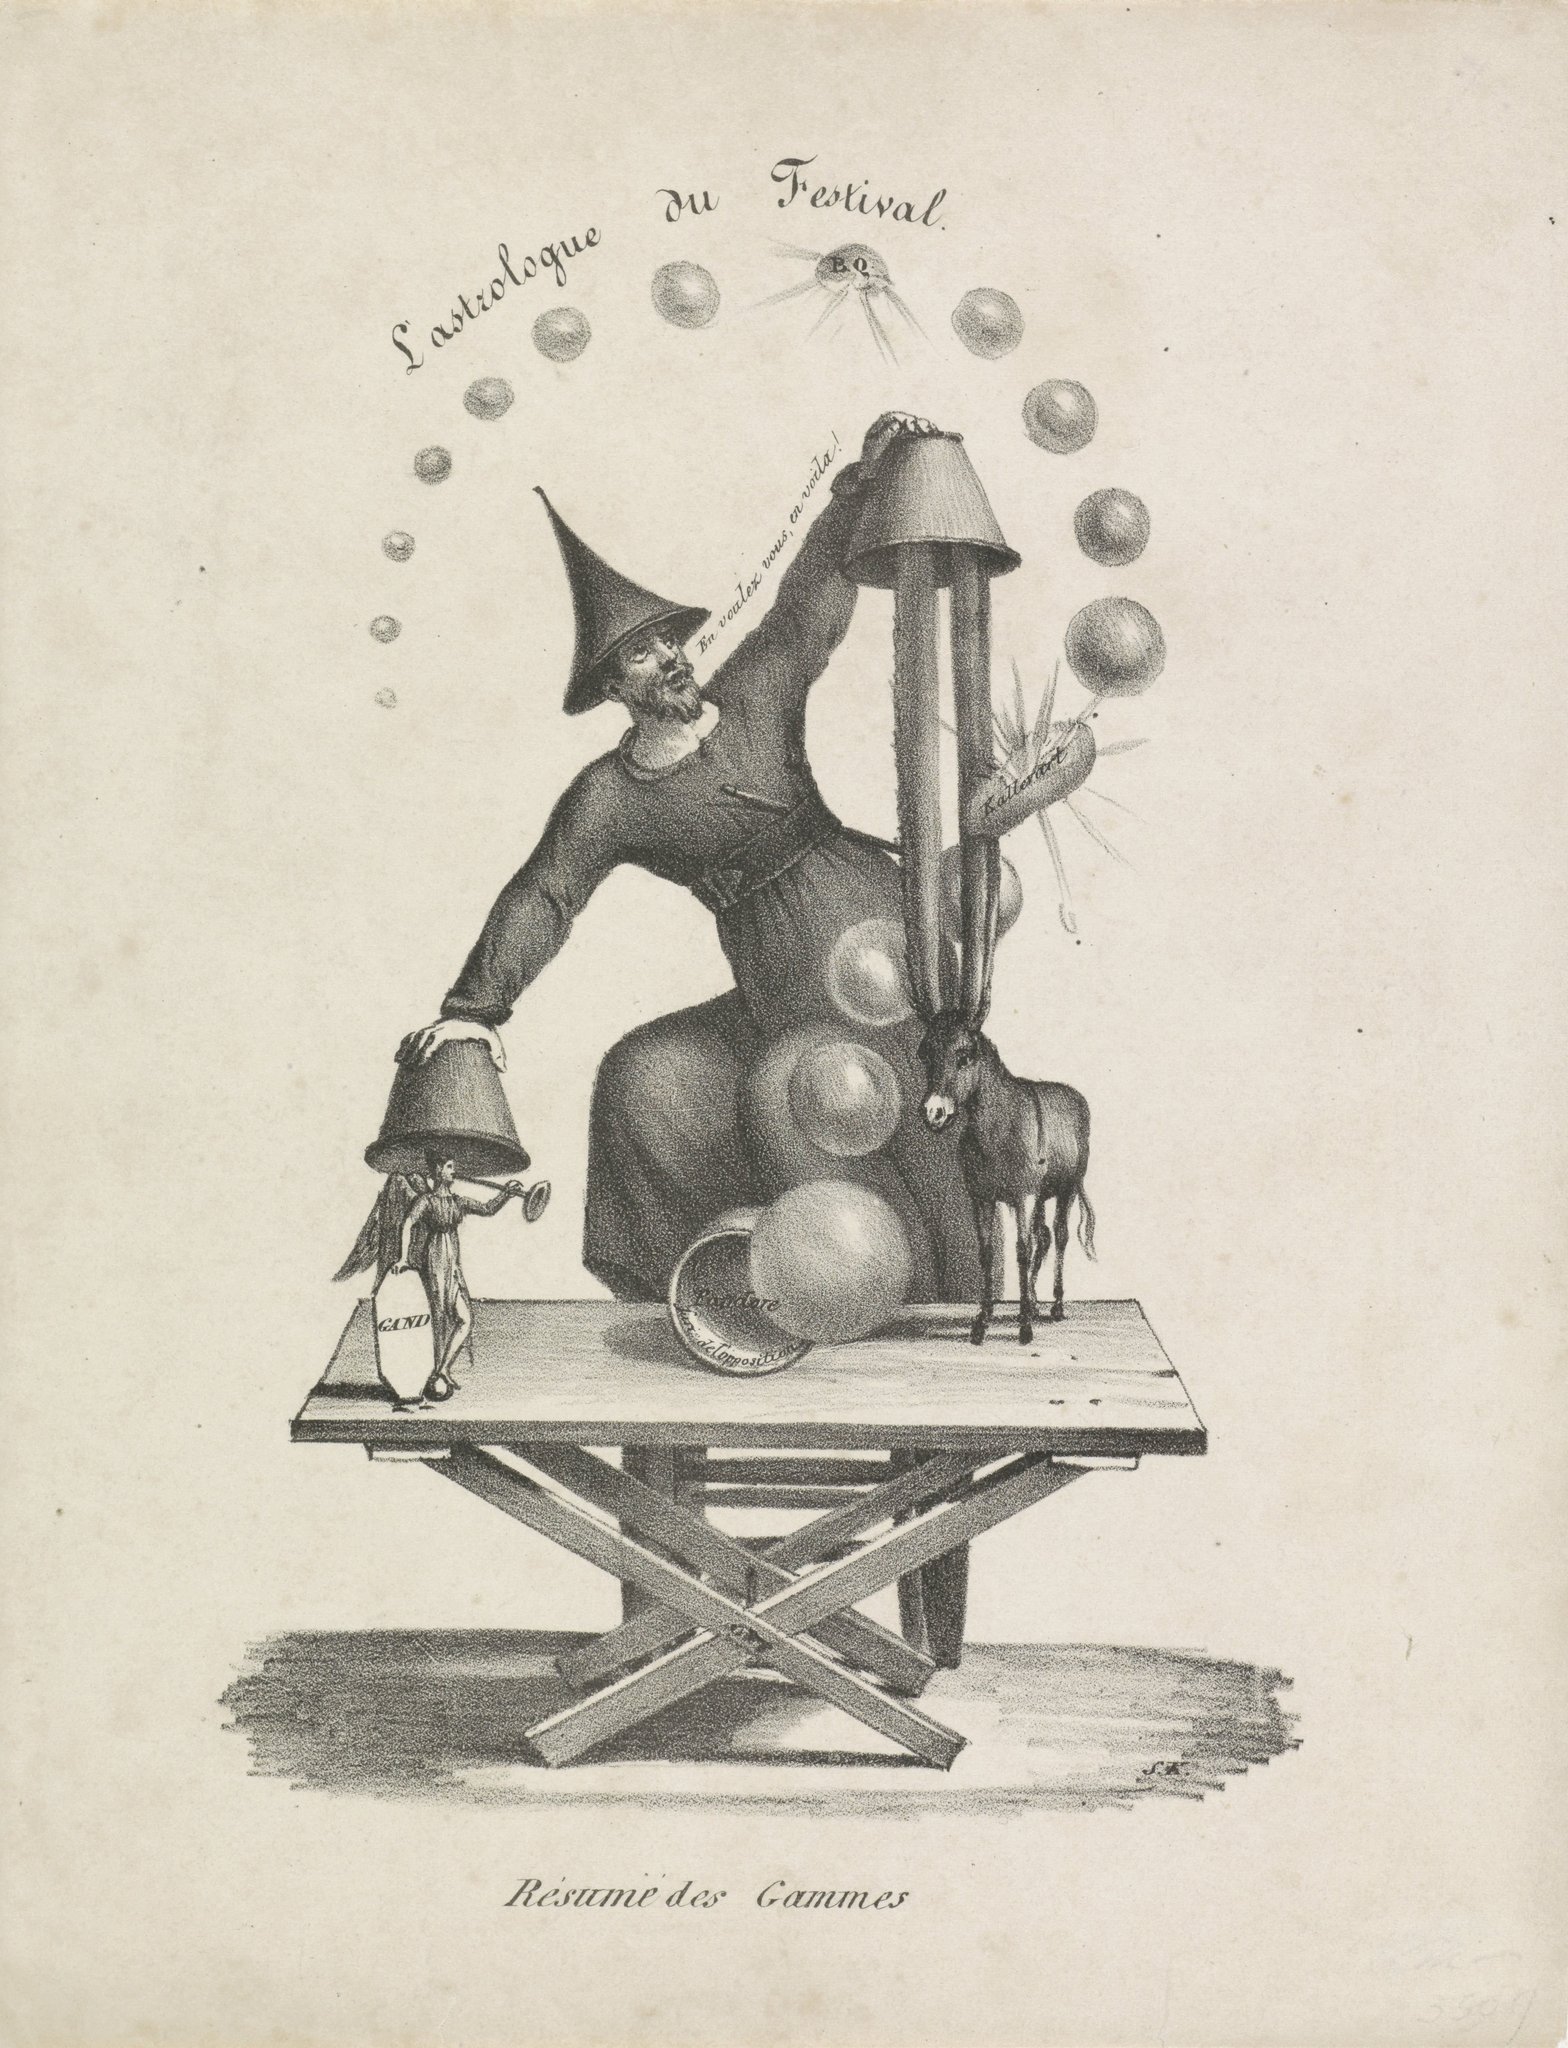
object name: cartoon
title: Spotprent op het muziekconcours te Lille, 1829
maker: sophia k. kierdorff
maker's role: printer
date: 1829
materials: paper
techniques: lithograph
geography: southern netherlands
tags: ass, donkey, attributes of pandora: box, distribution of awards ~ art contest, illusionist, conjurer, juggler, 'legerdemain', sorcerer, magician, wizard, warlock, competition, art contest, ghent, brussels, lille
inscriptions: collector's mark: Lugt 2228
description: Spotprent op het muziekconcours gehouden te Lille op 30 juni 1829. Een goochelaar op een stellage tilt links een beker op waaronder een beeldje van Victoria voor Gent, onder de beker rechts een ezel met enorm lange oren. In het midden de geopende doos van Pandora waaruit zeepbellen opstijgen. Er ontstond onenigheid of de Vereeniging St. Caecilia uit Gent of de Harmonie van Brussel de eerste prijs op de muziek concours gehouden te Lille had gewonnen.